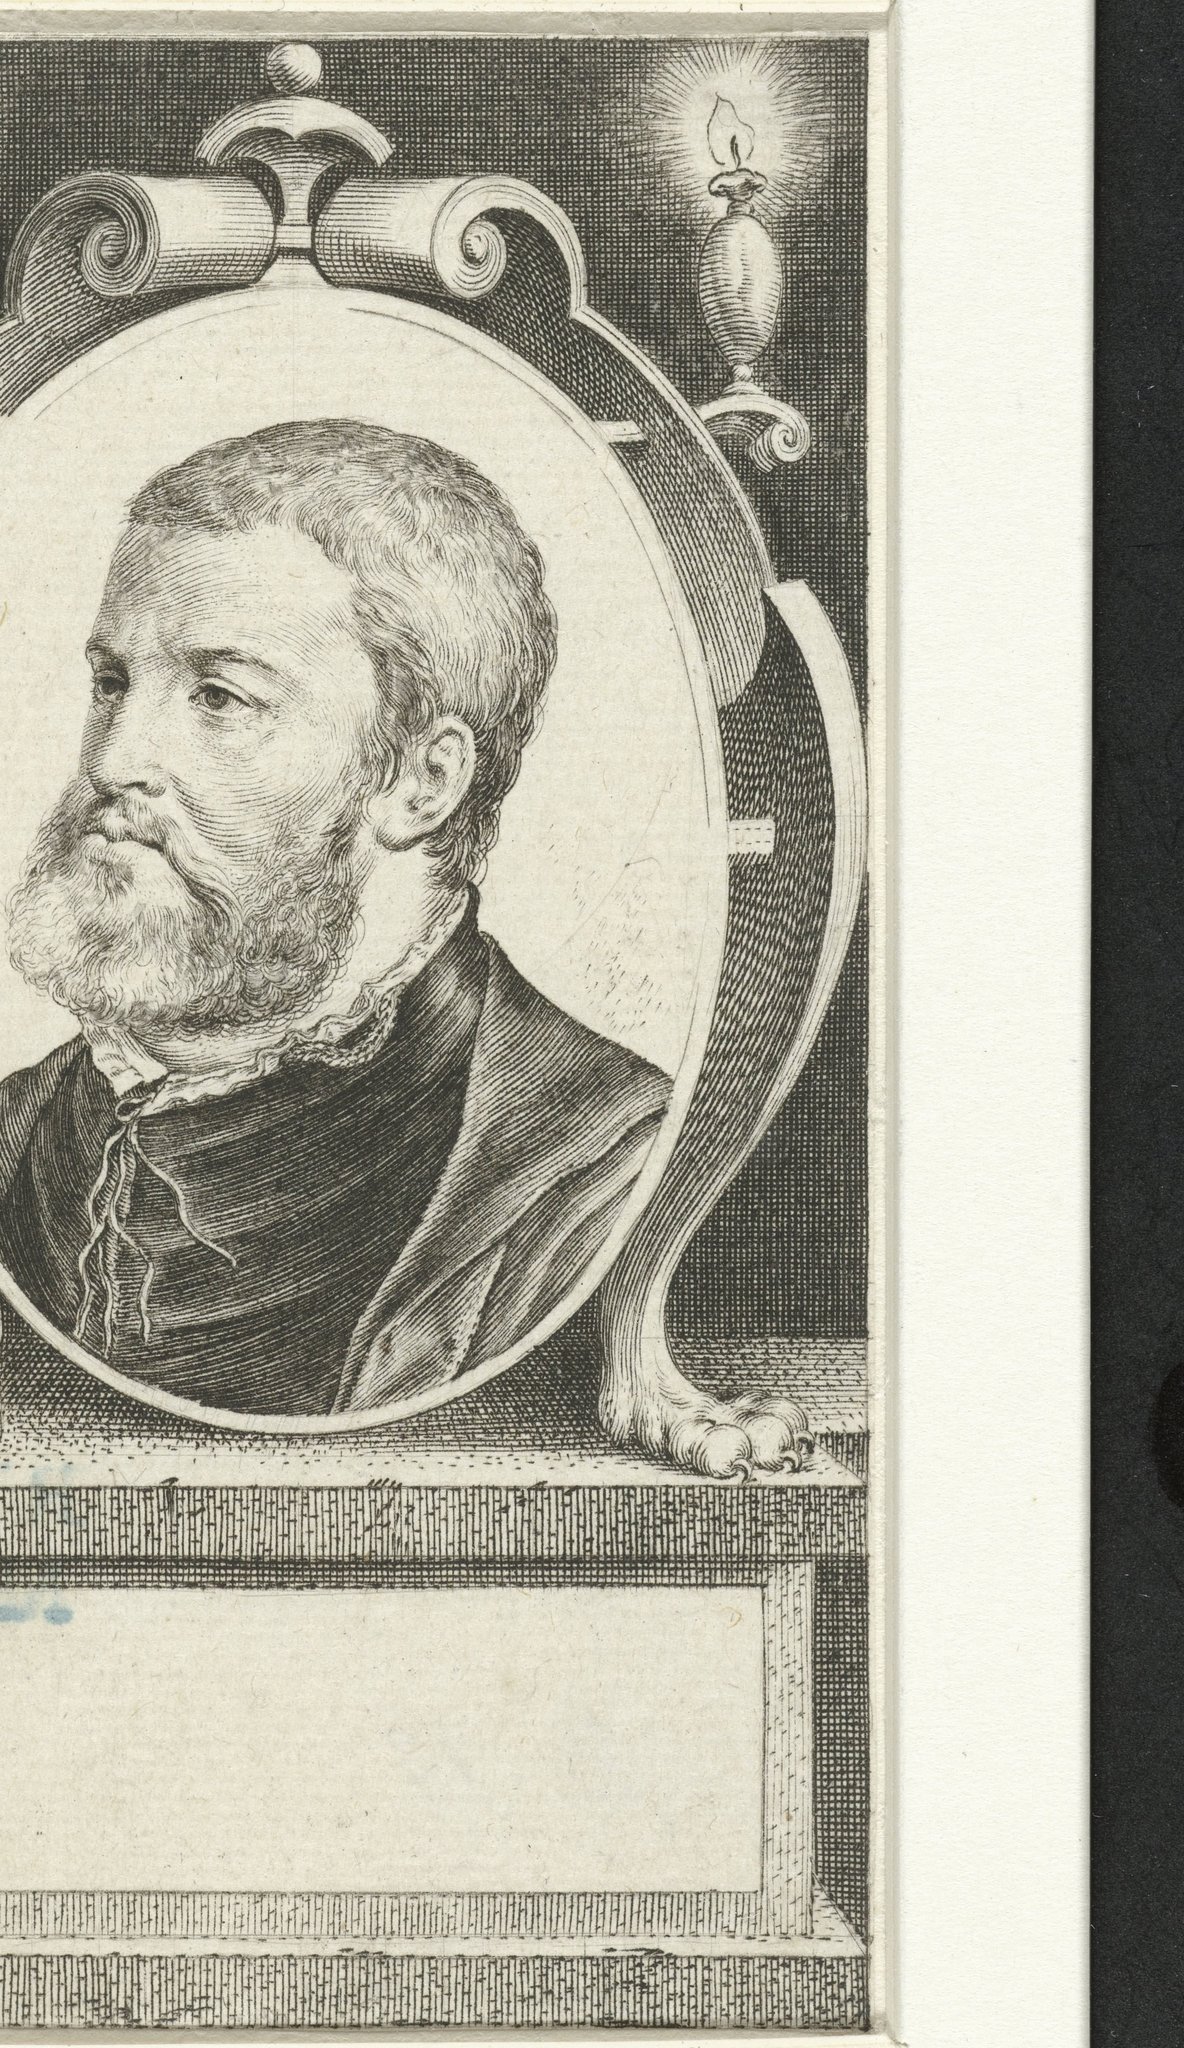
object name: print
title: Portret van Nicolaas Grudius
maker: jan harmensz. muller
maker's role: draughtsman, print maker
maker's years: 1571-1628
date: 1610-1614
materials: paper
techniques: engraving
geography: amsterdam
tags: venice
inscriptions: collector's mark: Lugt 2165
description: Portret van Nicolaas Grudius, raadsheer van Karel V en secretaris van het Gulden Vlies. Het portret is gevat in een ornamentele lijst op poten en aan weerszijden brandende kandelaars.